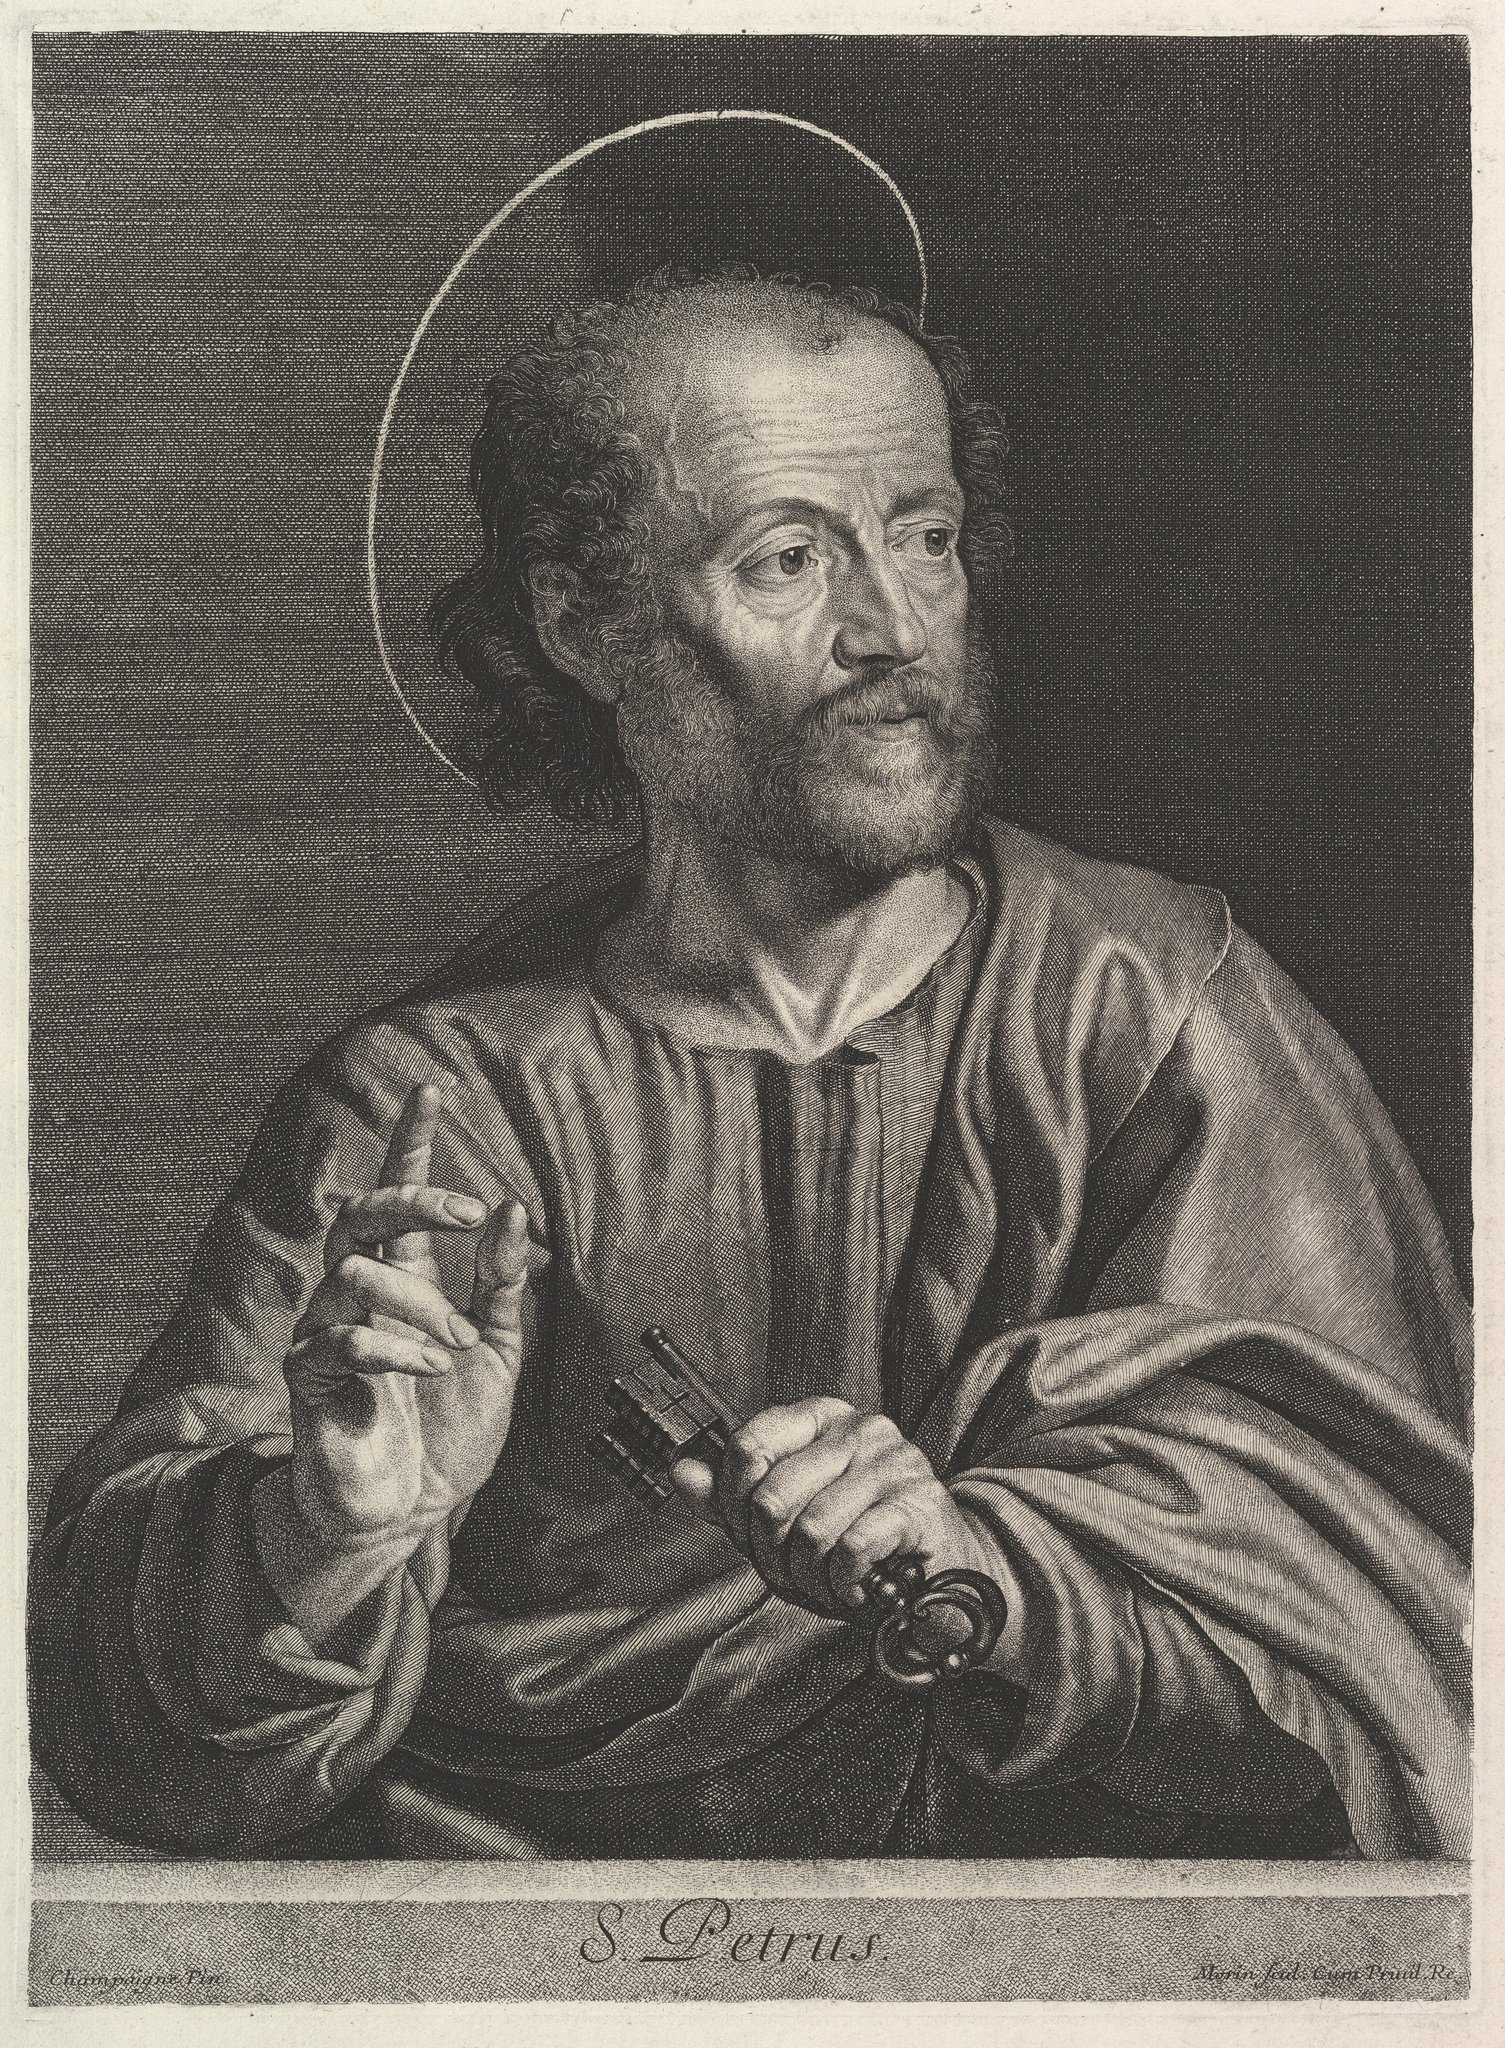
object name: print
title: Saint Pierre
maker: jean morin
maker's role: artist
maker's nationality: french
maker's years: 1605-1650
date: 1605-1650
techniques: etching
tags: saints,keys